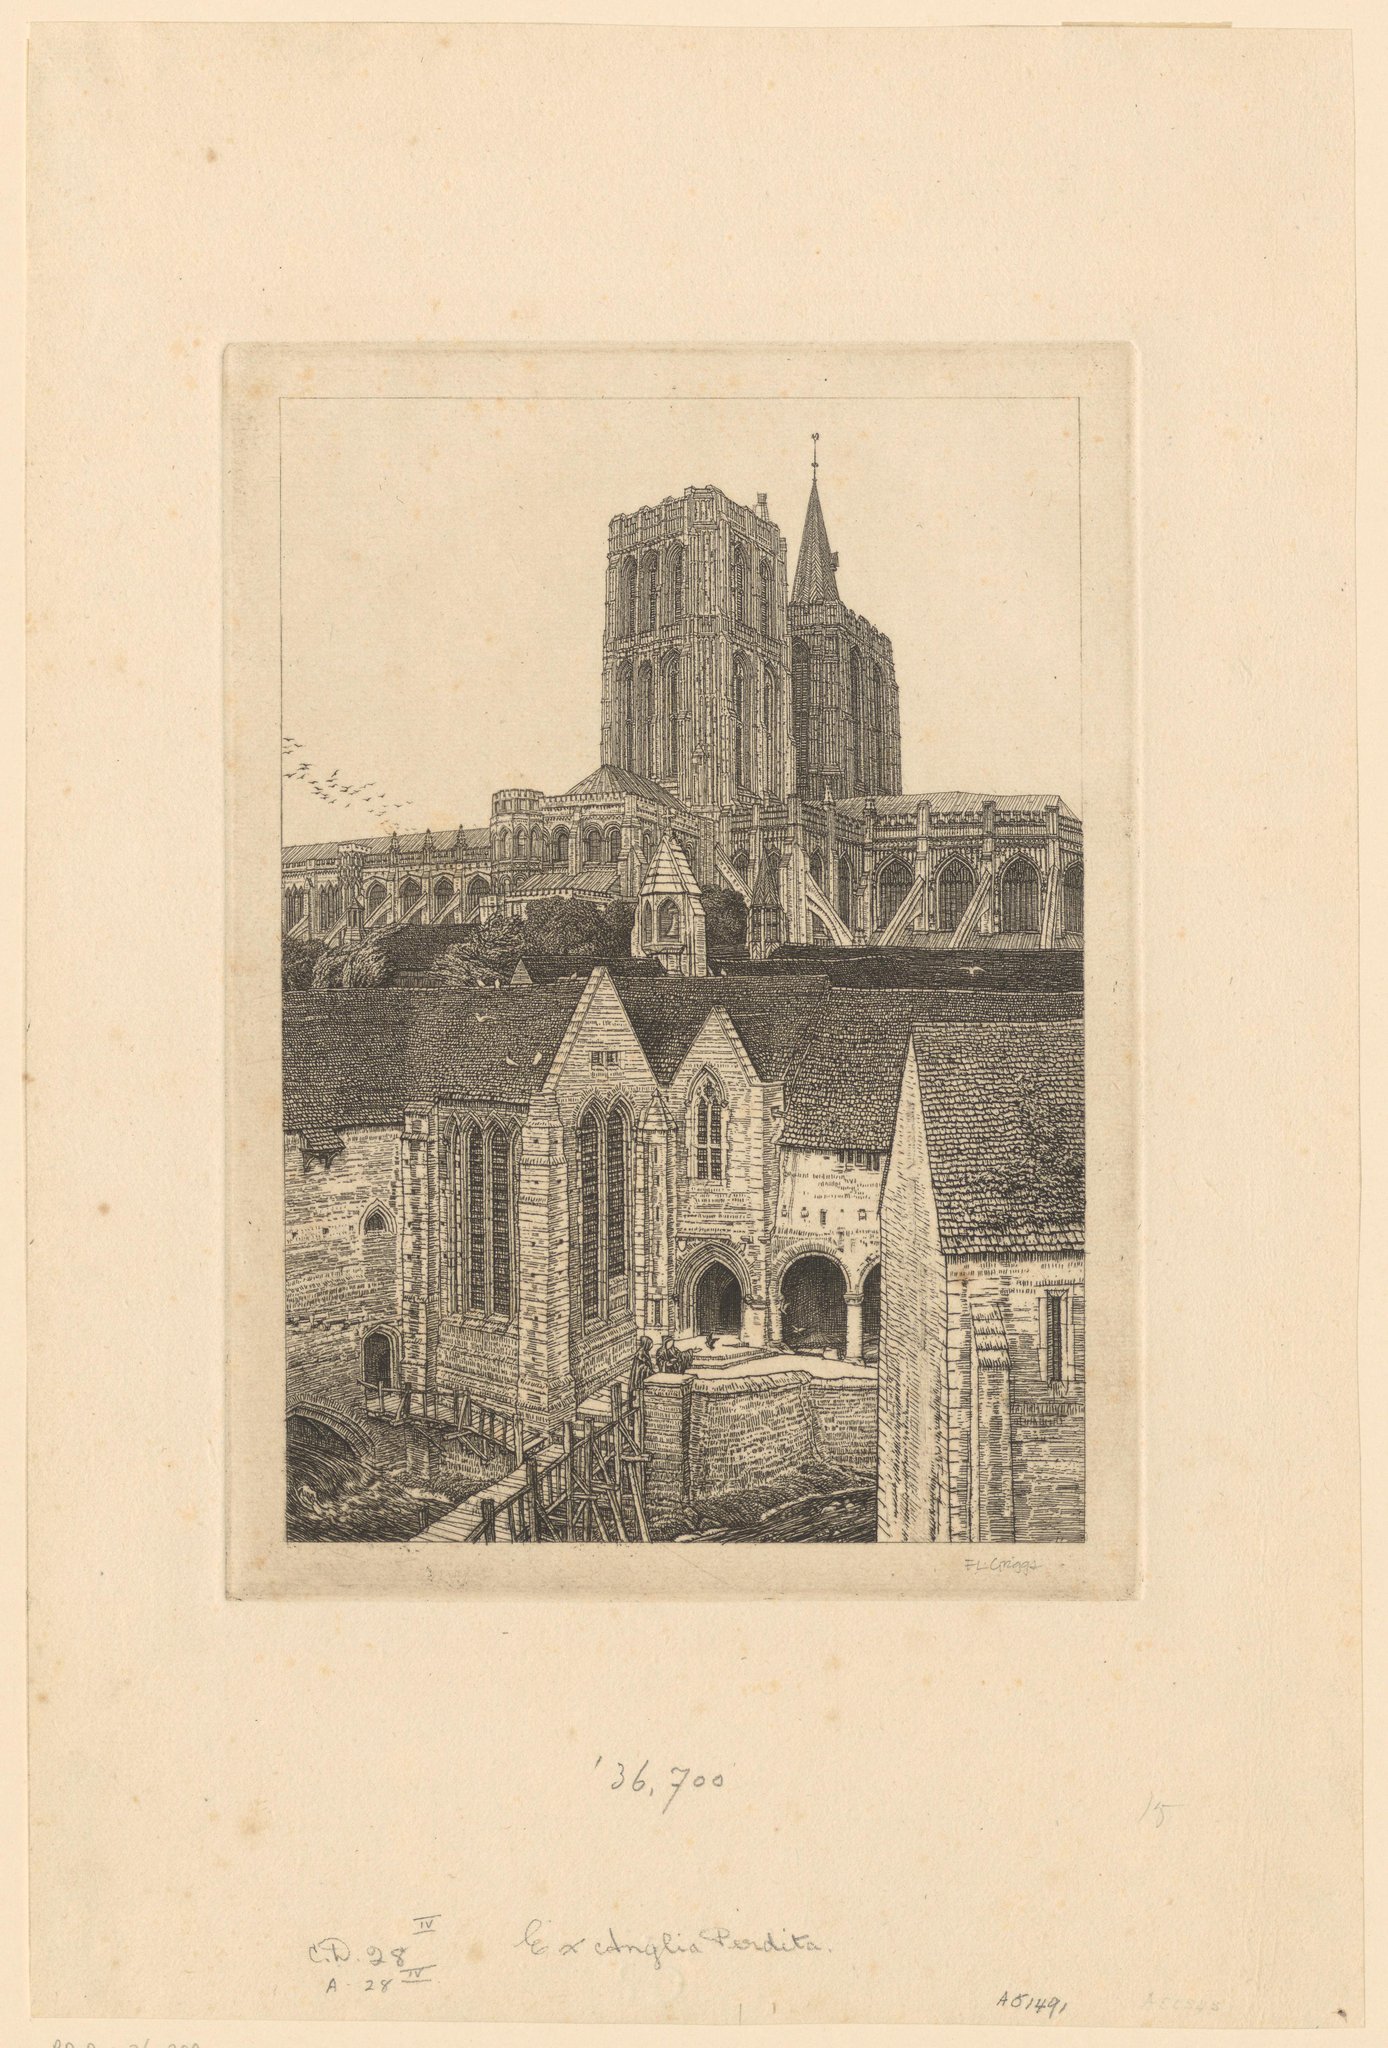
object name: print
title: Anglia Perdita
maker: frederick landseer maur griggs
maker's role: print maker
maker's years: 1876-1938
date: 1921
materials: paper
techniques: etching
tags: abbey, monastery, convent ~ roman catholic church, church (exterior), monk(s), friar(s)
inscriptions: signature: ‘F.L. Griggs’, collector's mark: Lugt 2228, collector's mark: Lugt 760a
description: De eerste staat van de prent komt uit 1921, de aanpassingen van deze vijfde staat uit 1925.